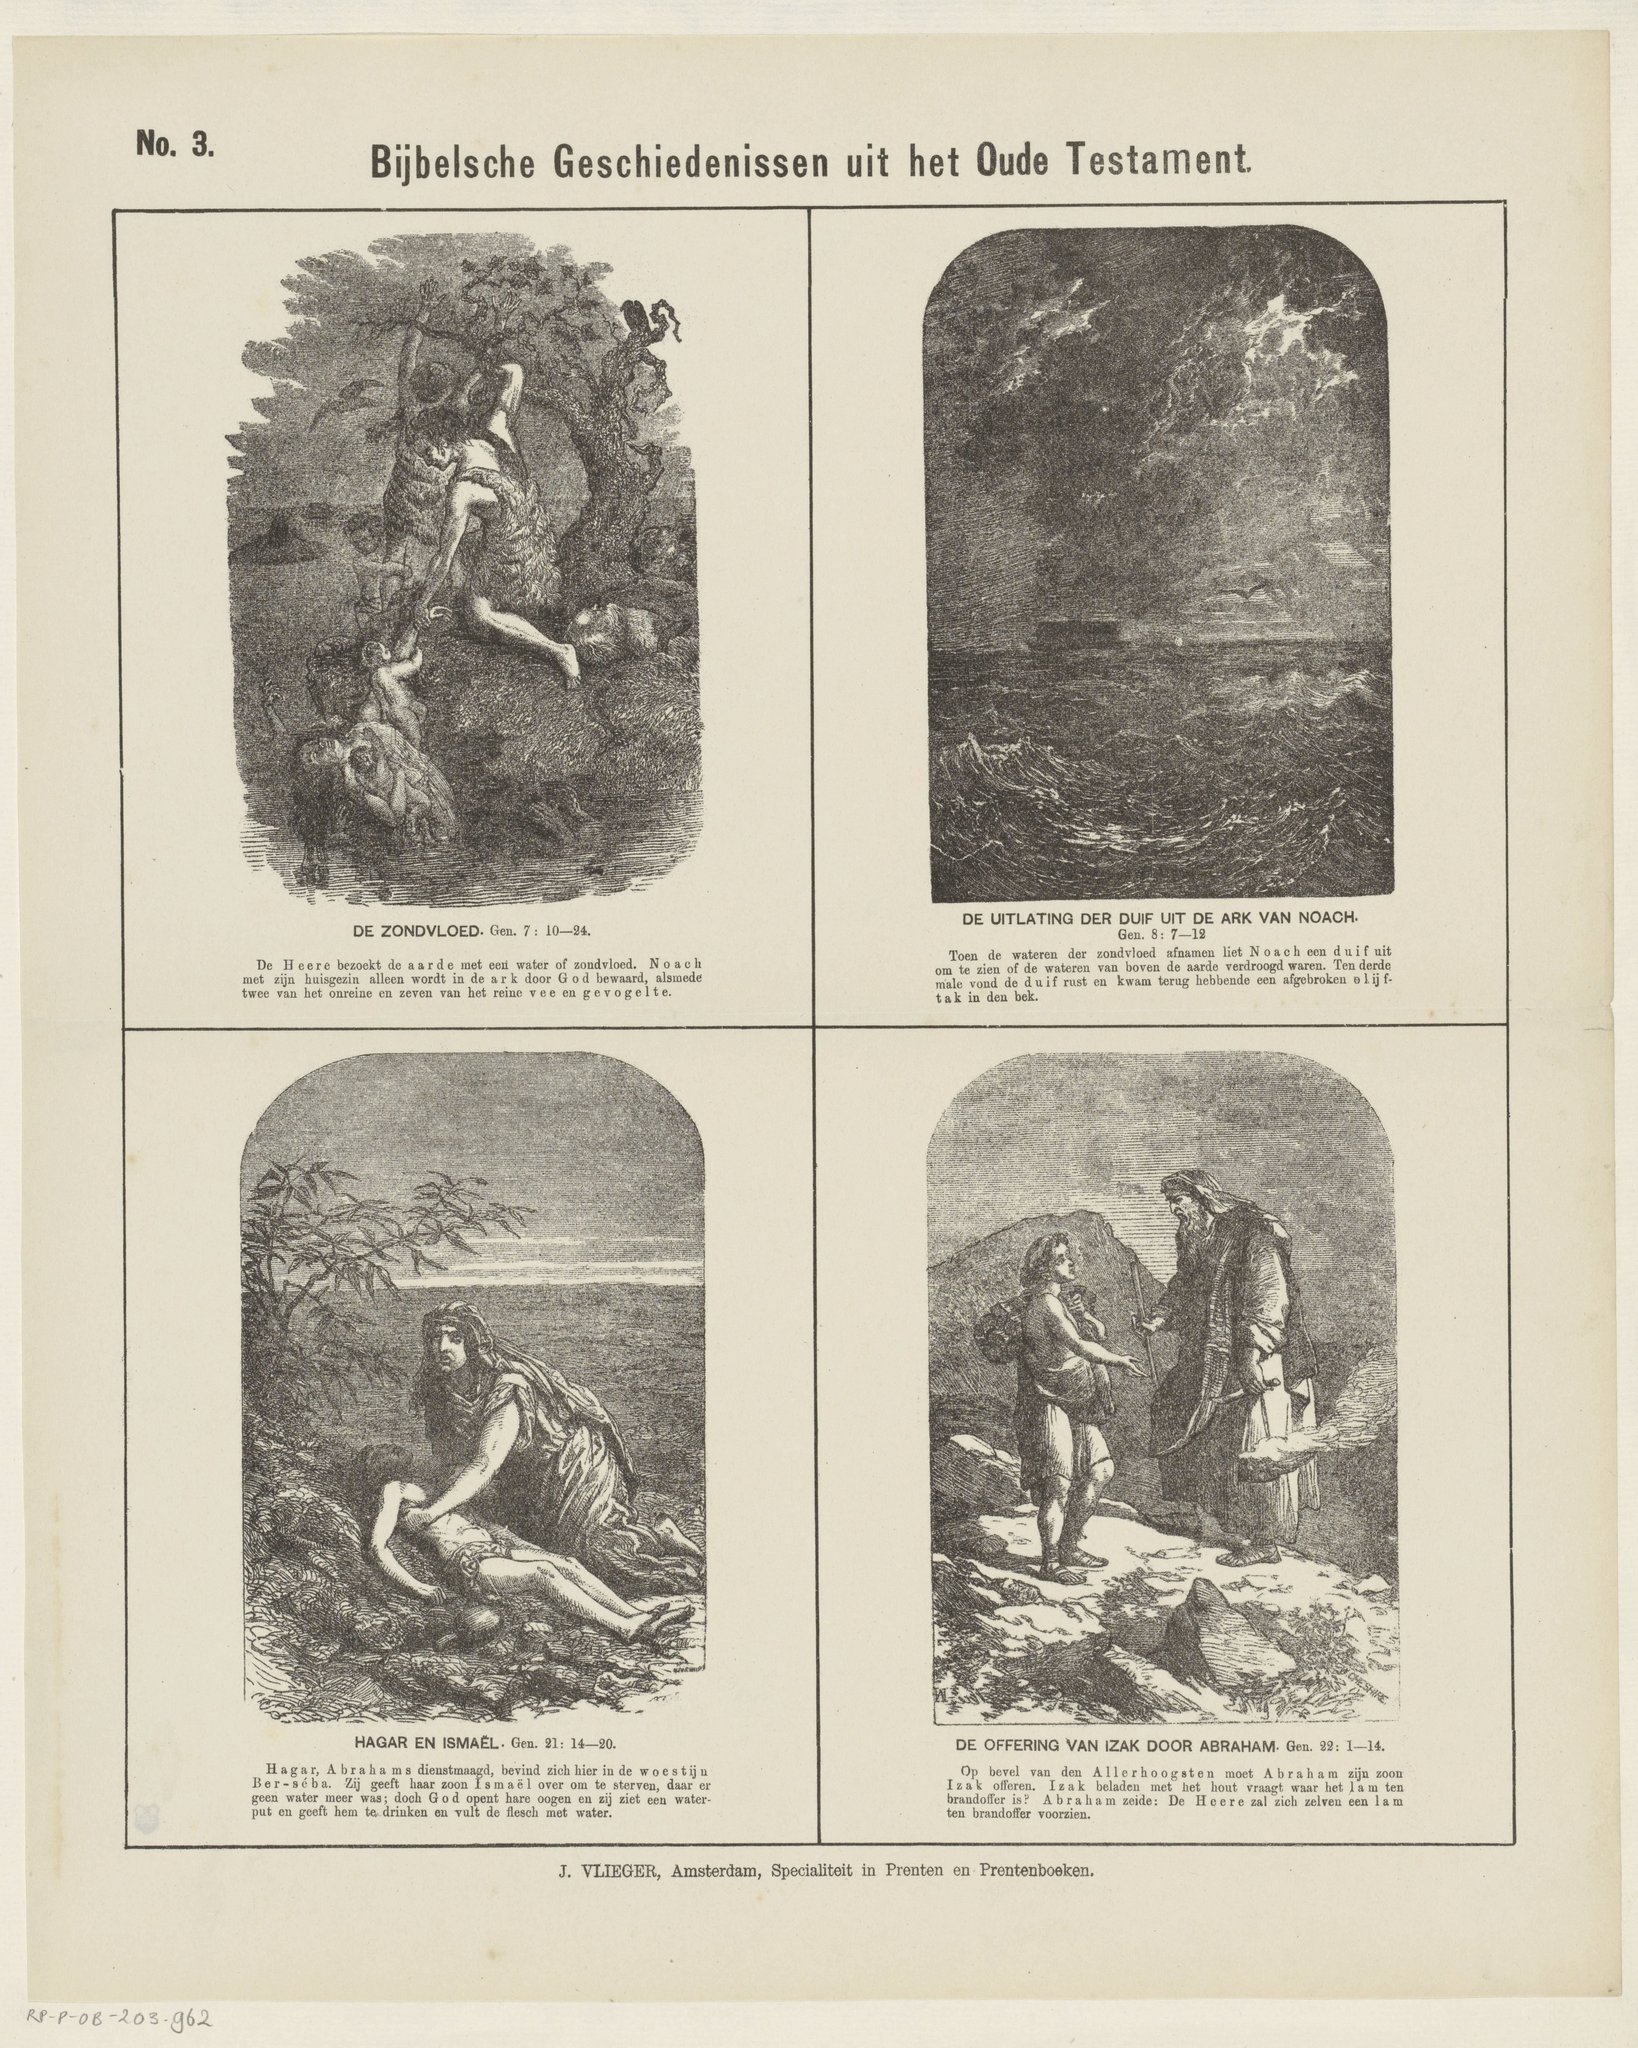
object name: print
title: Bijbelsche geschiedenissen uit het Oude Testament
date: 1871-1908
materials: paper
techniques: letterpress printing, engraving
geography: amsterdam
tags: the sacrifice of isaac (genesis 22), the flood and destruction of mankind ~ story of noah (genesis 7:10 - 8:17), noah sends off a raven which does not return, old testament, hagar and ishmael in the wilderness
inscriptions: collector's mark: Lugt 2760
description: Blad met 4 voorstellingen van verhalen uit het Oude Testament. De zondvloed, Noach zendt een raaf uit, Hagar en Ismaël en Abraham en het offer van Isaak. Onder elke afbeelding de bijbehorende Bijbeltekst. Genummerd linksboven: No. 3.